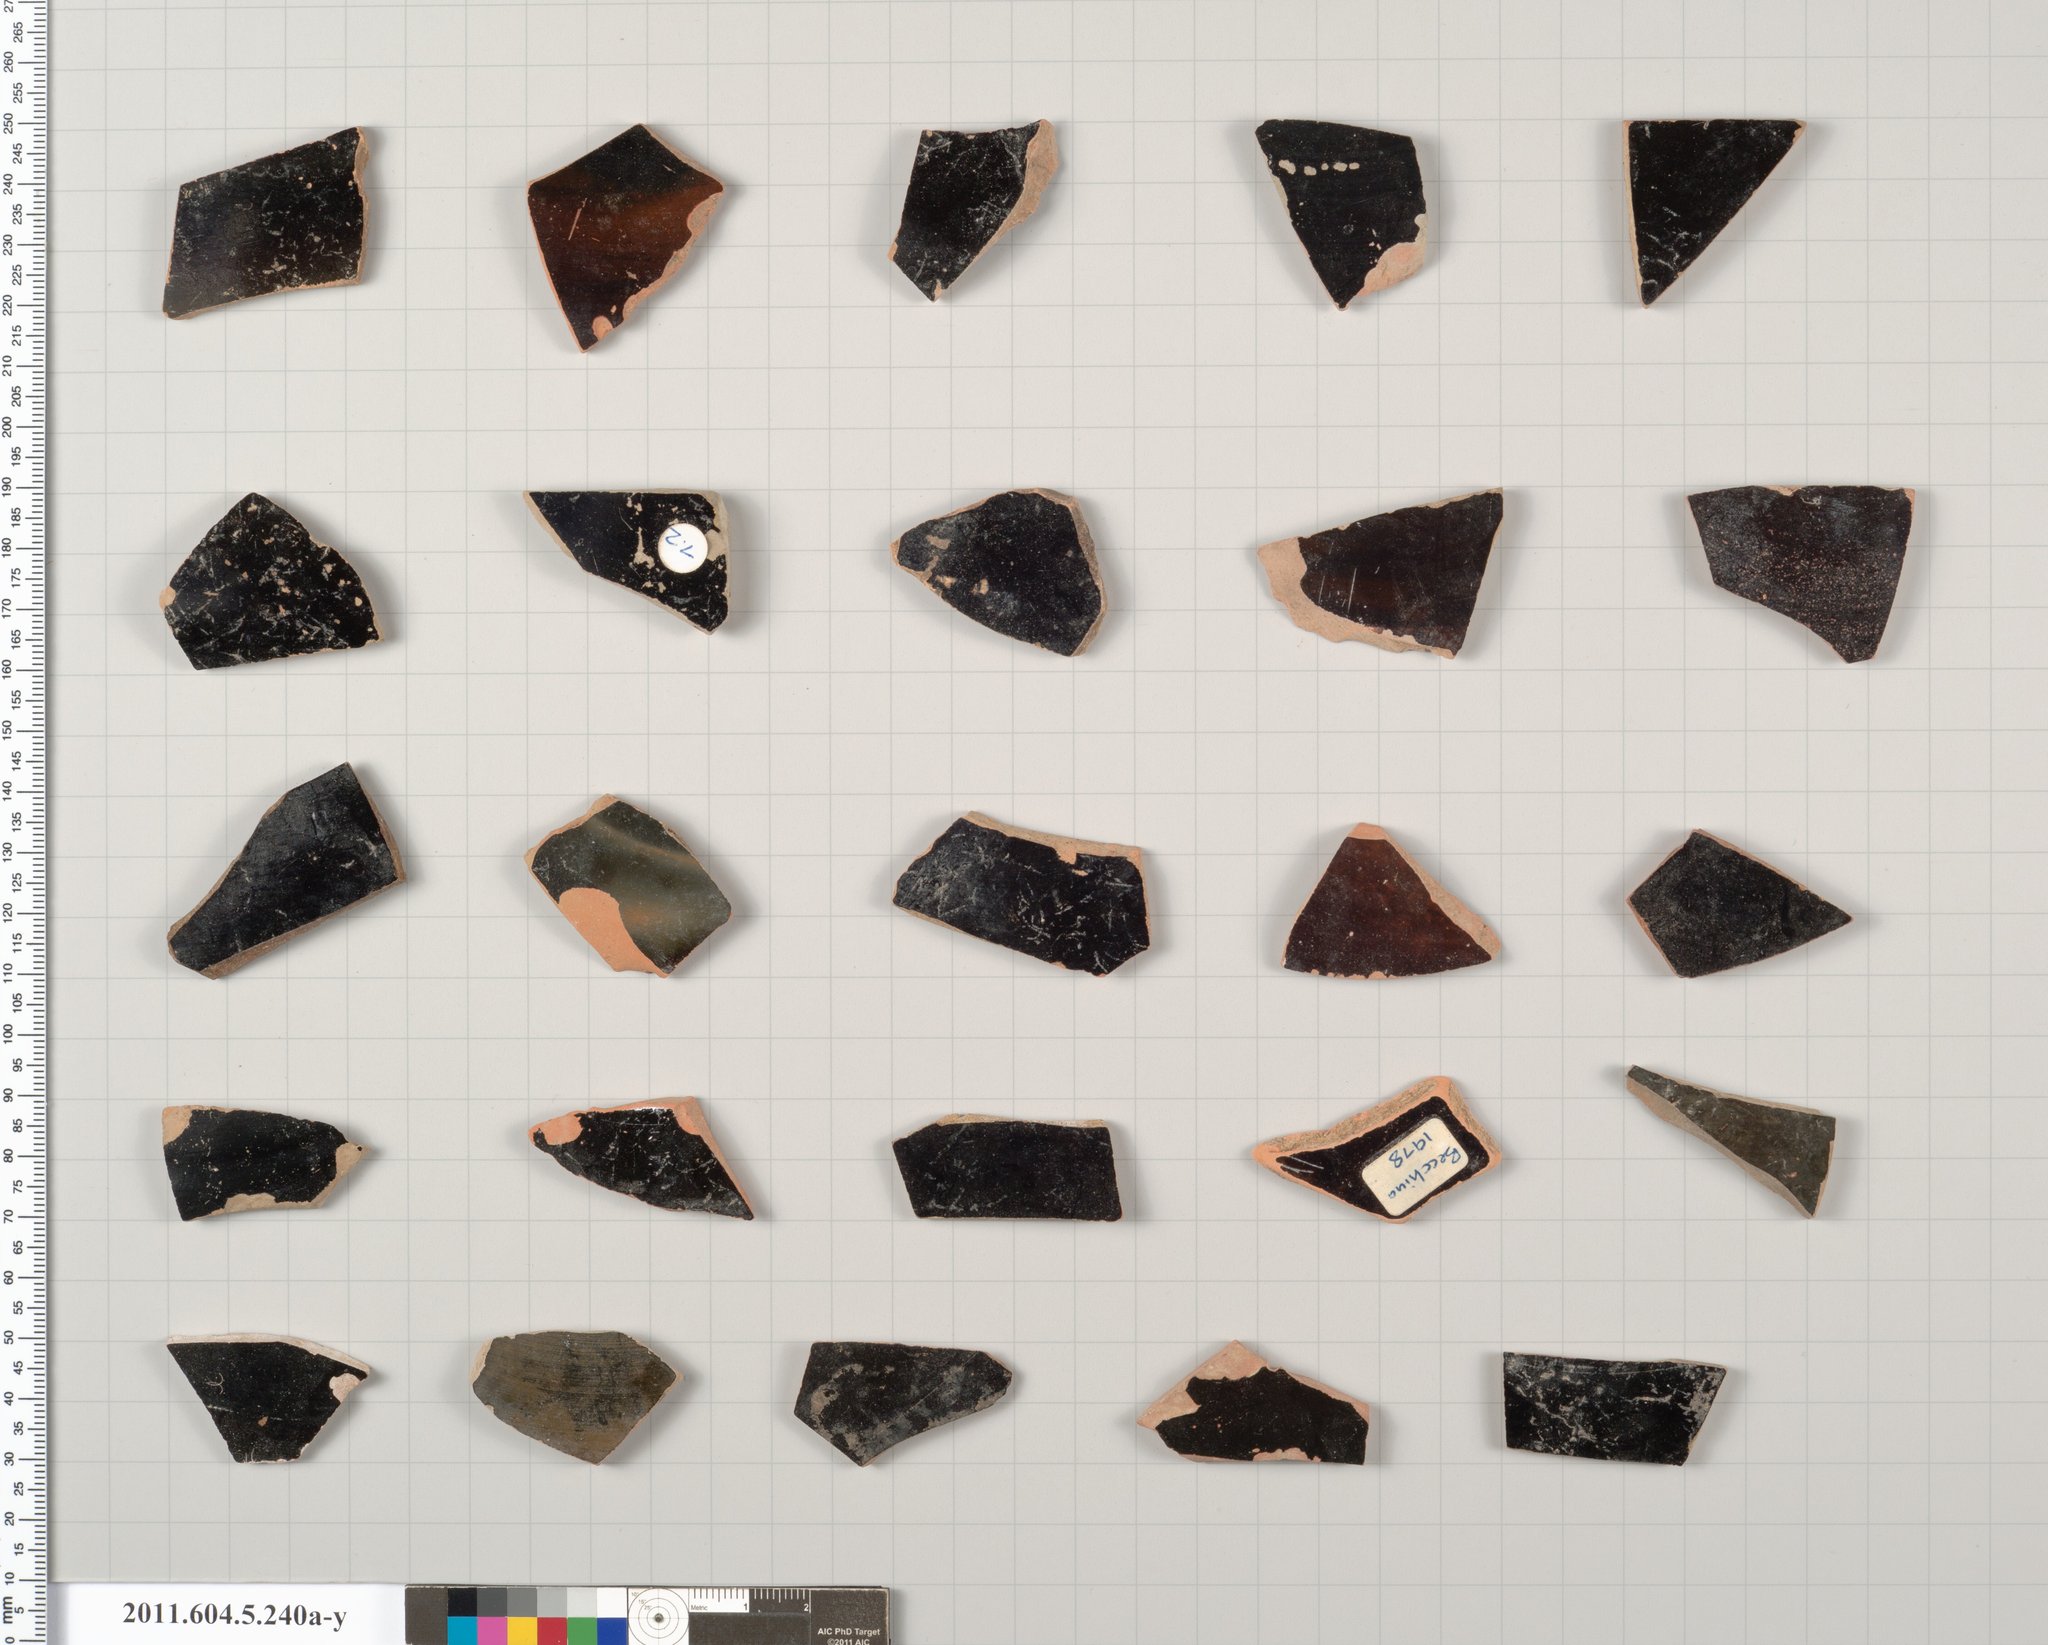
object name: kylix fragment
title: Terracotta fragments of kylikes (drinking cups)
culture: greek, attic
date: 600-401 BCE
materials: terracotta